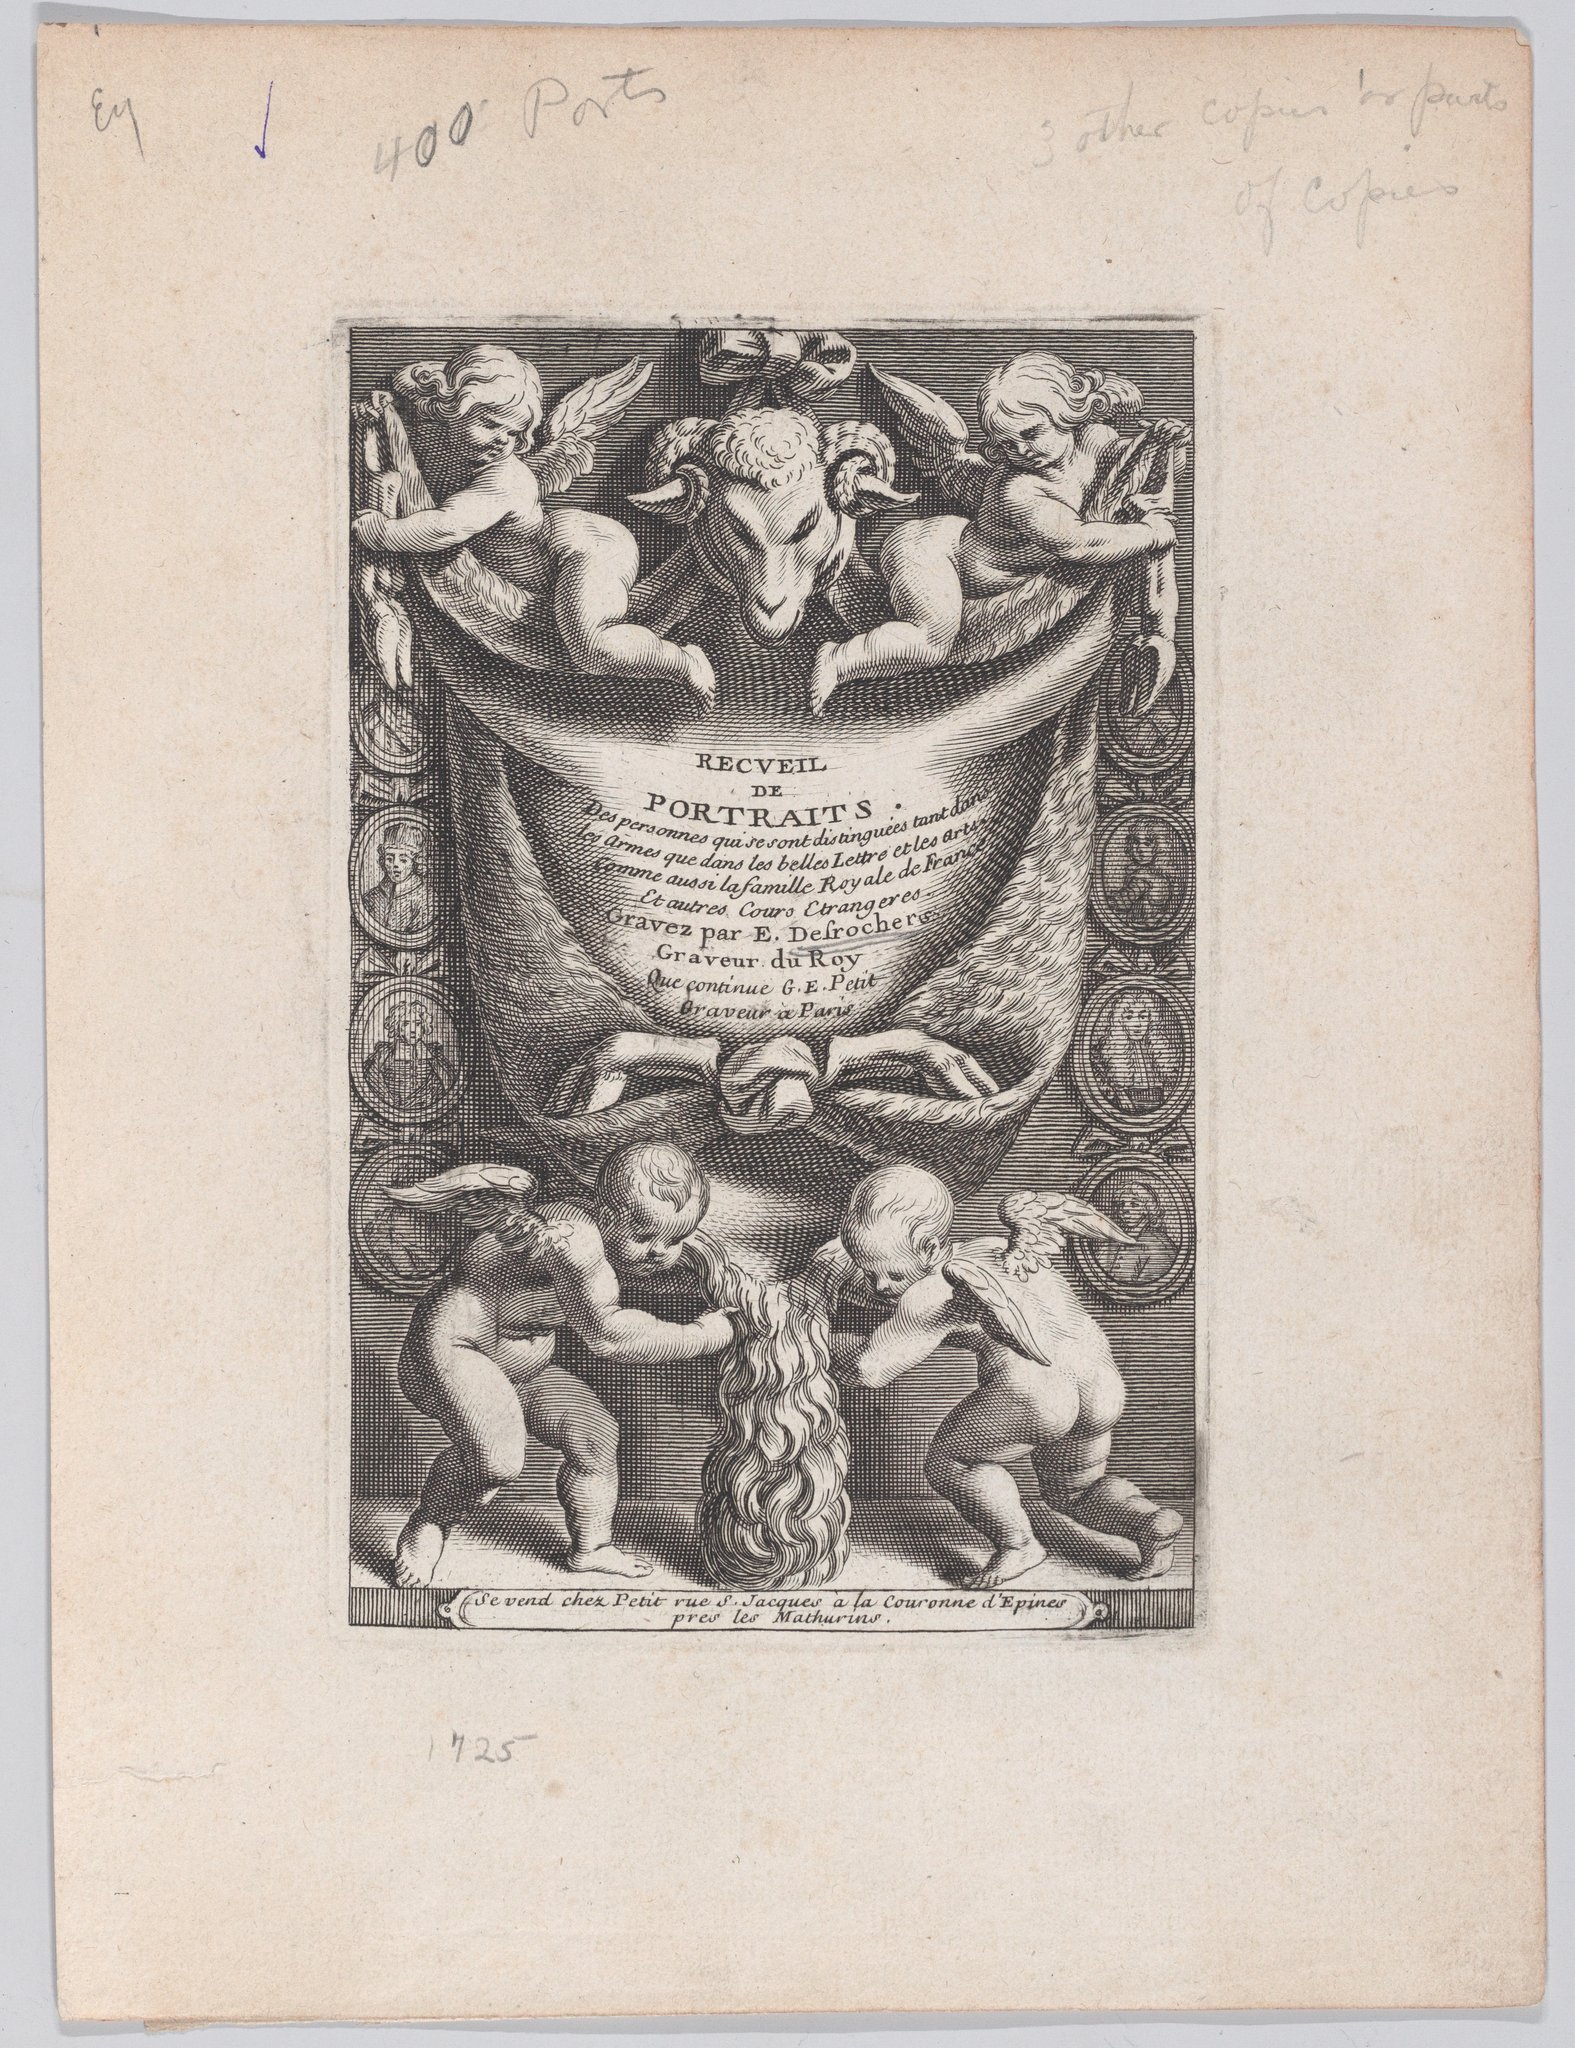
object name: print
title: Frontispiece from "Collection of Portraits"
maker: etienne jehandier desrochers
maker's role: artist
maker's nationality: french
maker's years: 1668-1741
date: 1714-1741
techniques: engraving